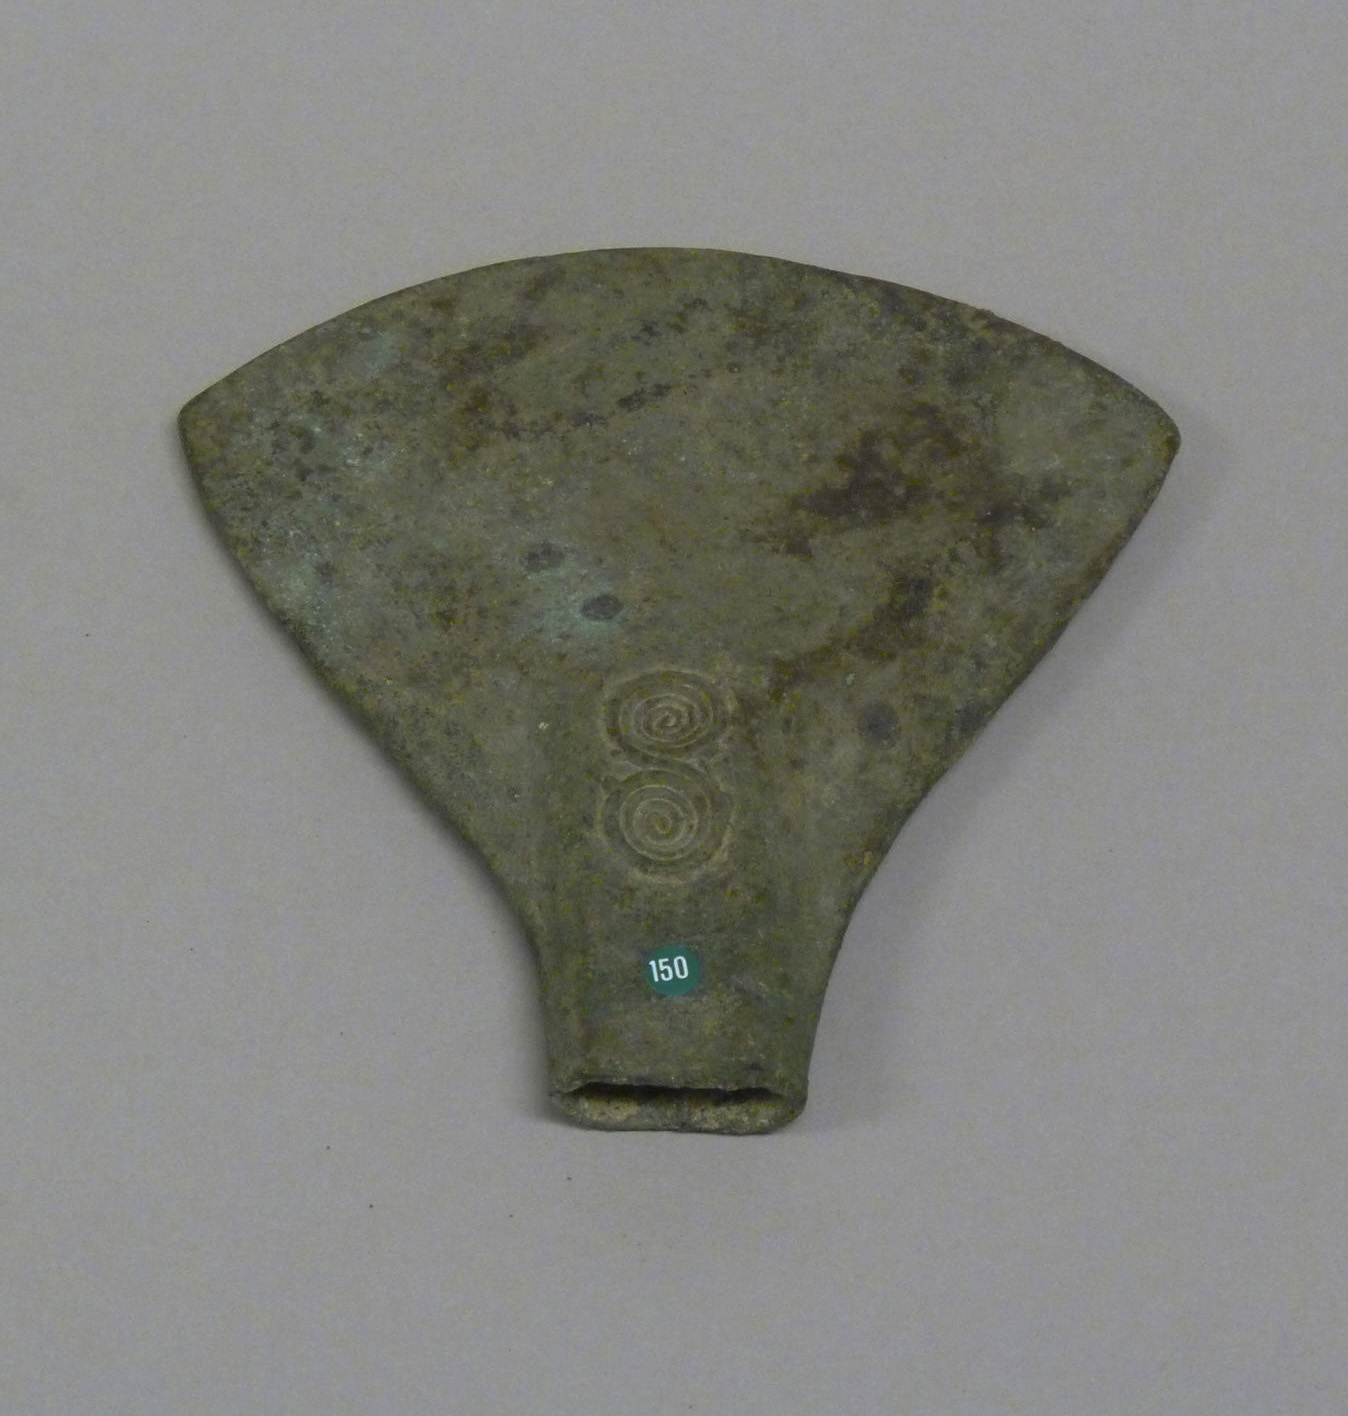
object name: hafted ax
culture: indonesian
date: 500 BCE-300 CE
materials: bronze